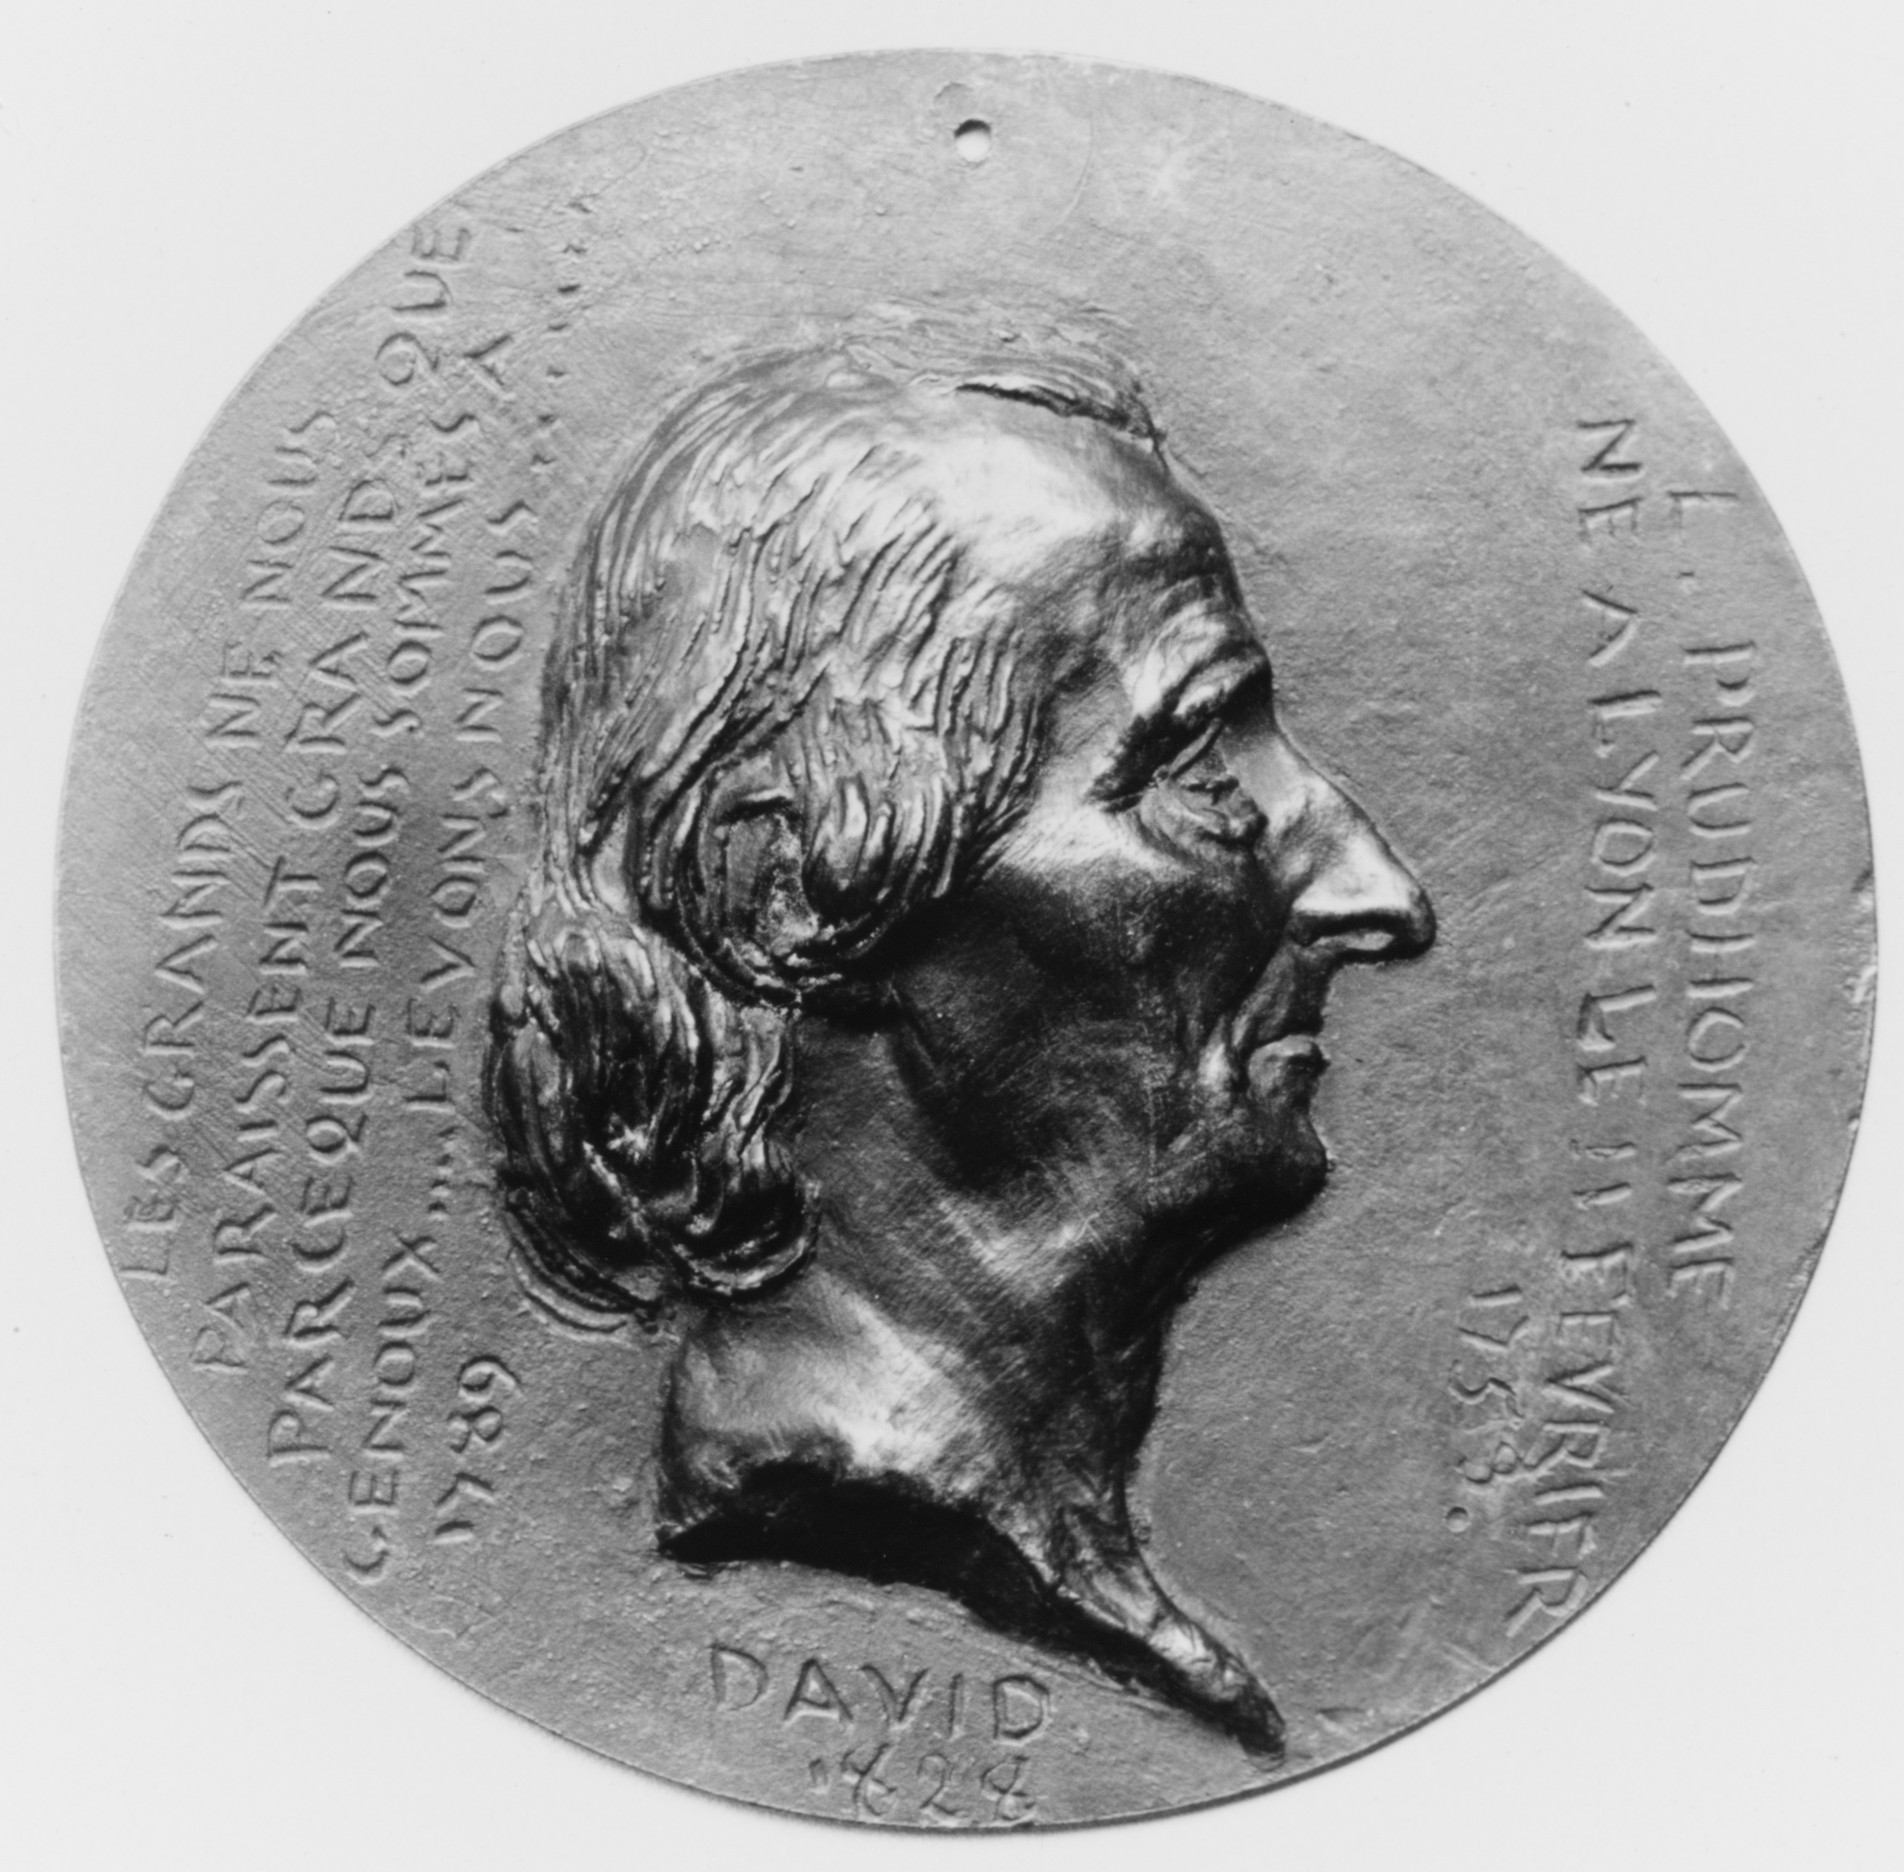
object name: medallion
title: Louis Prudhomme (1752–1830), French journalist and pamphleteer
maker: pierre jean david d'angers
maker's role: artist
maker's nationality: french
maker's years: 1788-1856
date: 1828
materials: bronze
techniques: casting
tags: men,profiles